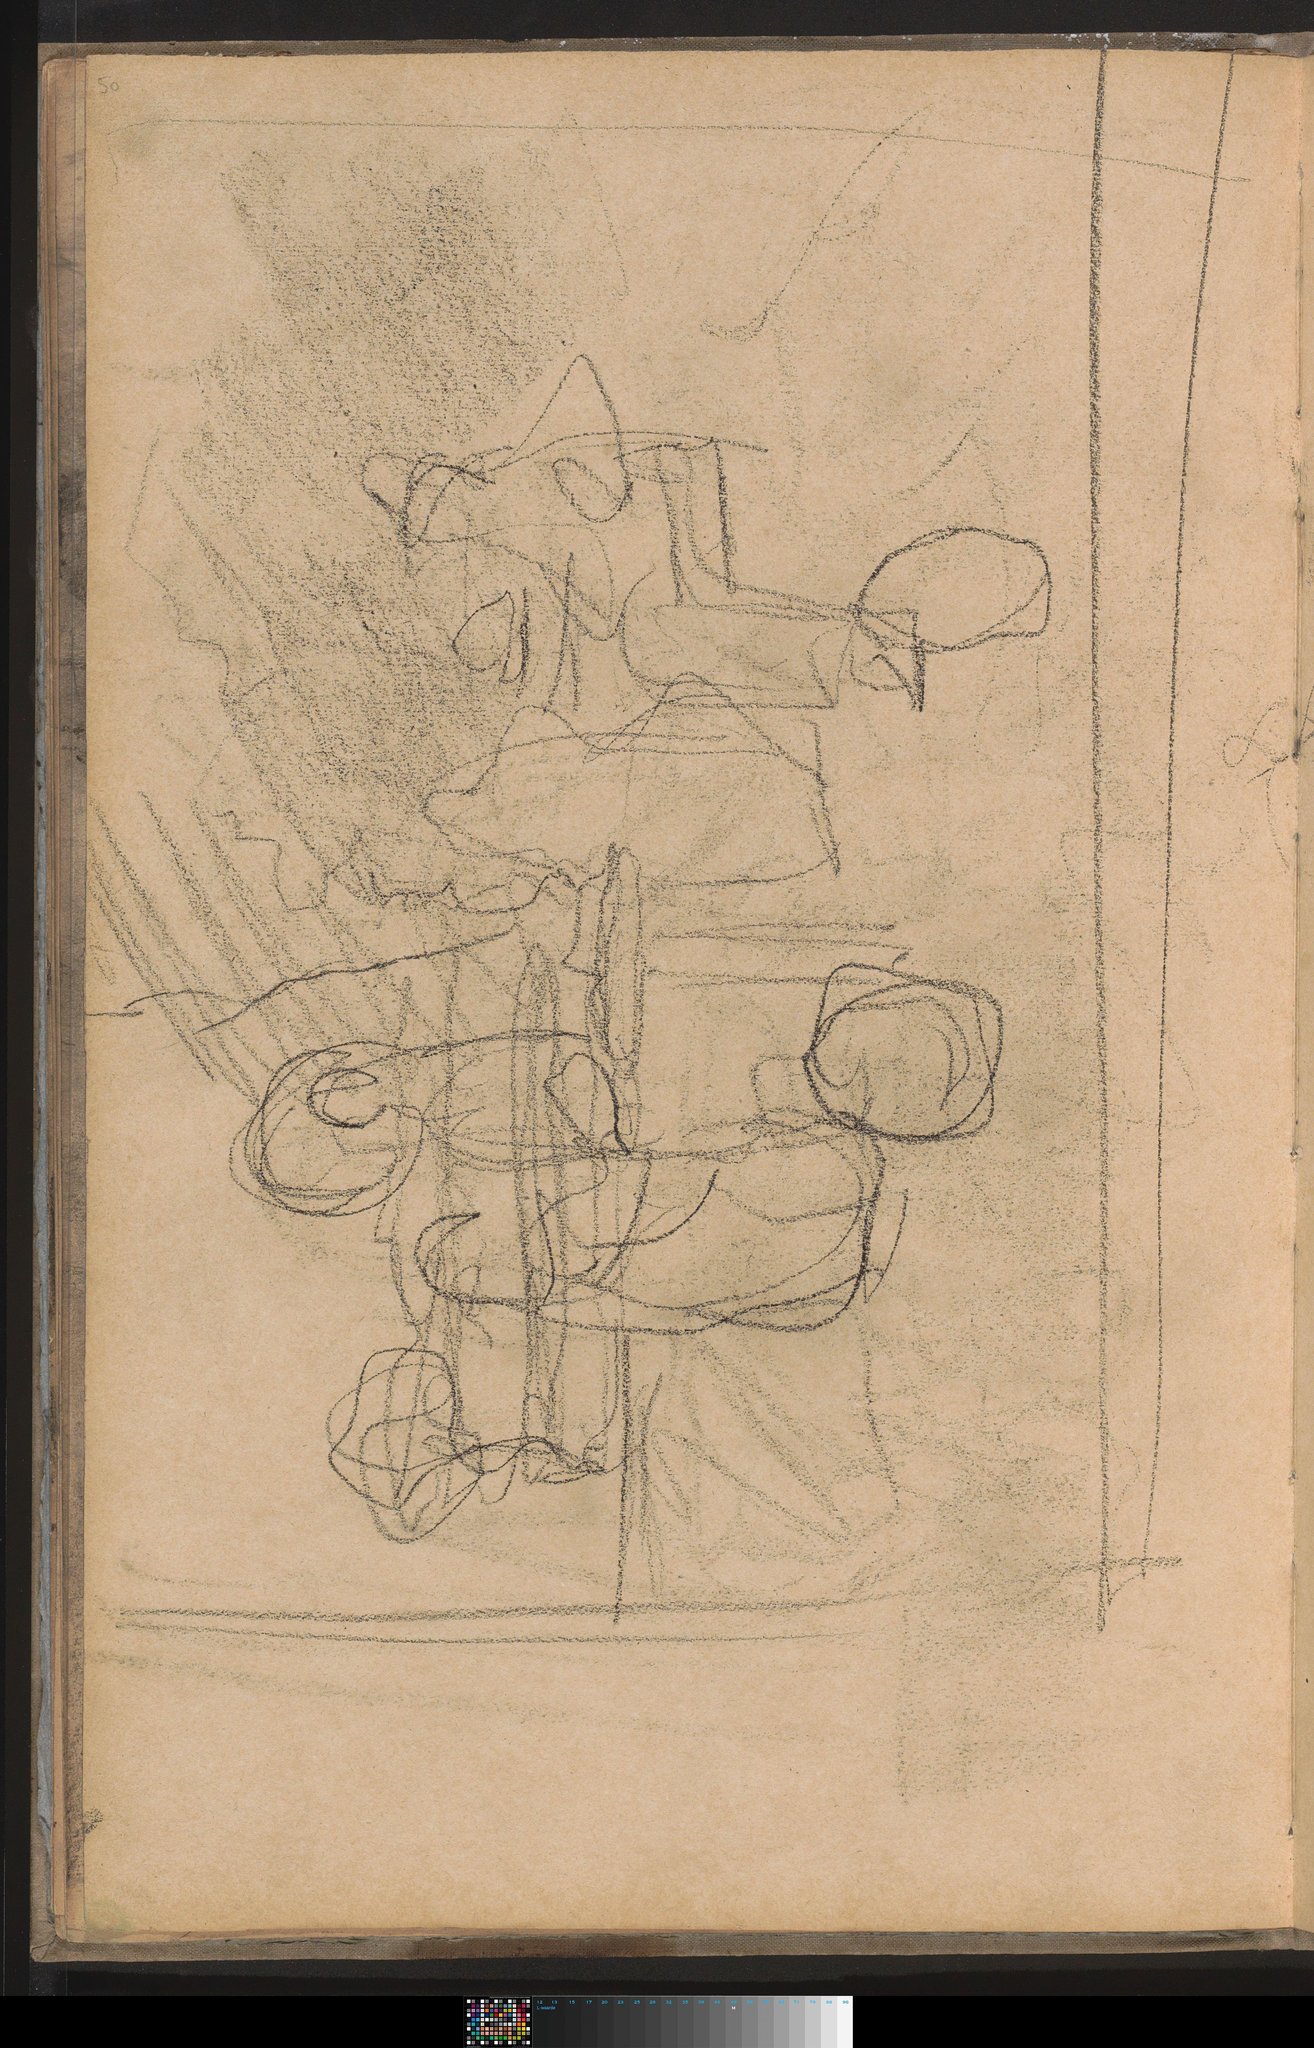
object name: sketchbook leaf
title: Groep figuren in een landschap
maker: willem witsen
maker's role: draughtsman, painter, print maker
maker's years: 1860-1923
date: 1884-1887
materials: chalk, paper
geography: ewijkshoeve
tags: landscapes in the temperate zone (+ landscape with figures, staffage)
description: Pagina 50 uit een schetsboek met 45 bladen vervaardigd rond de Ewijkshoeve.